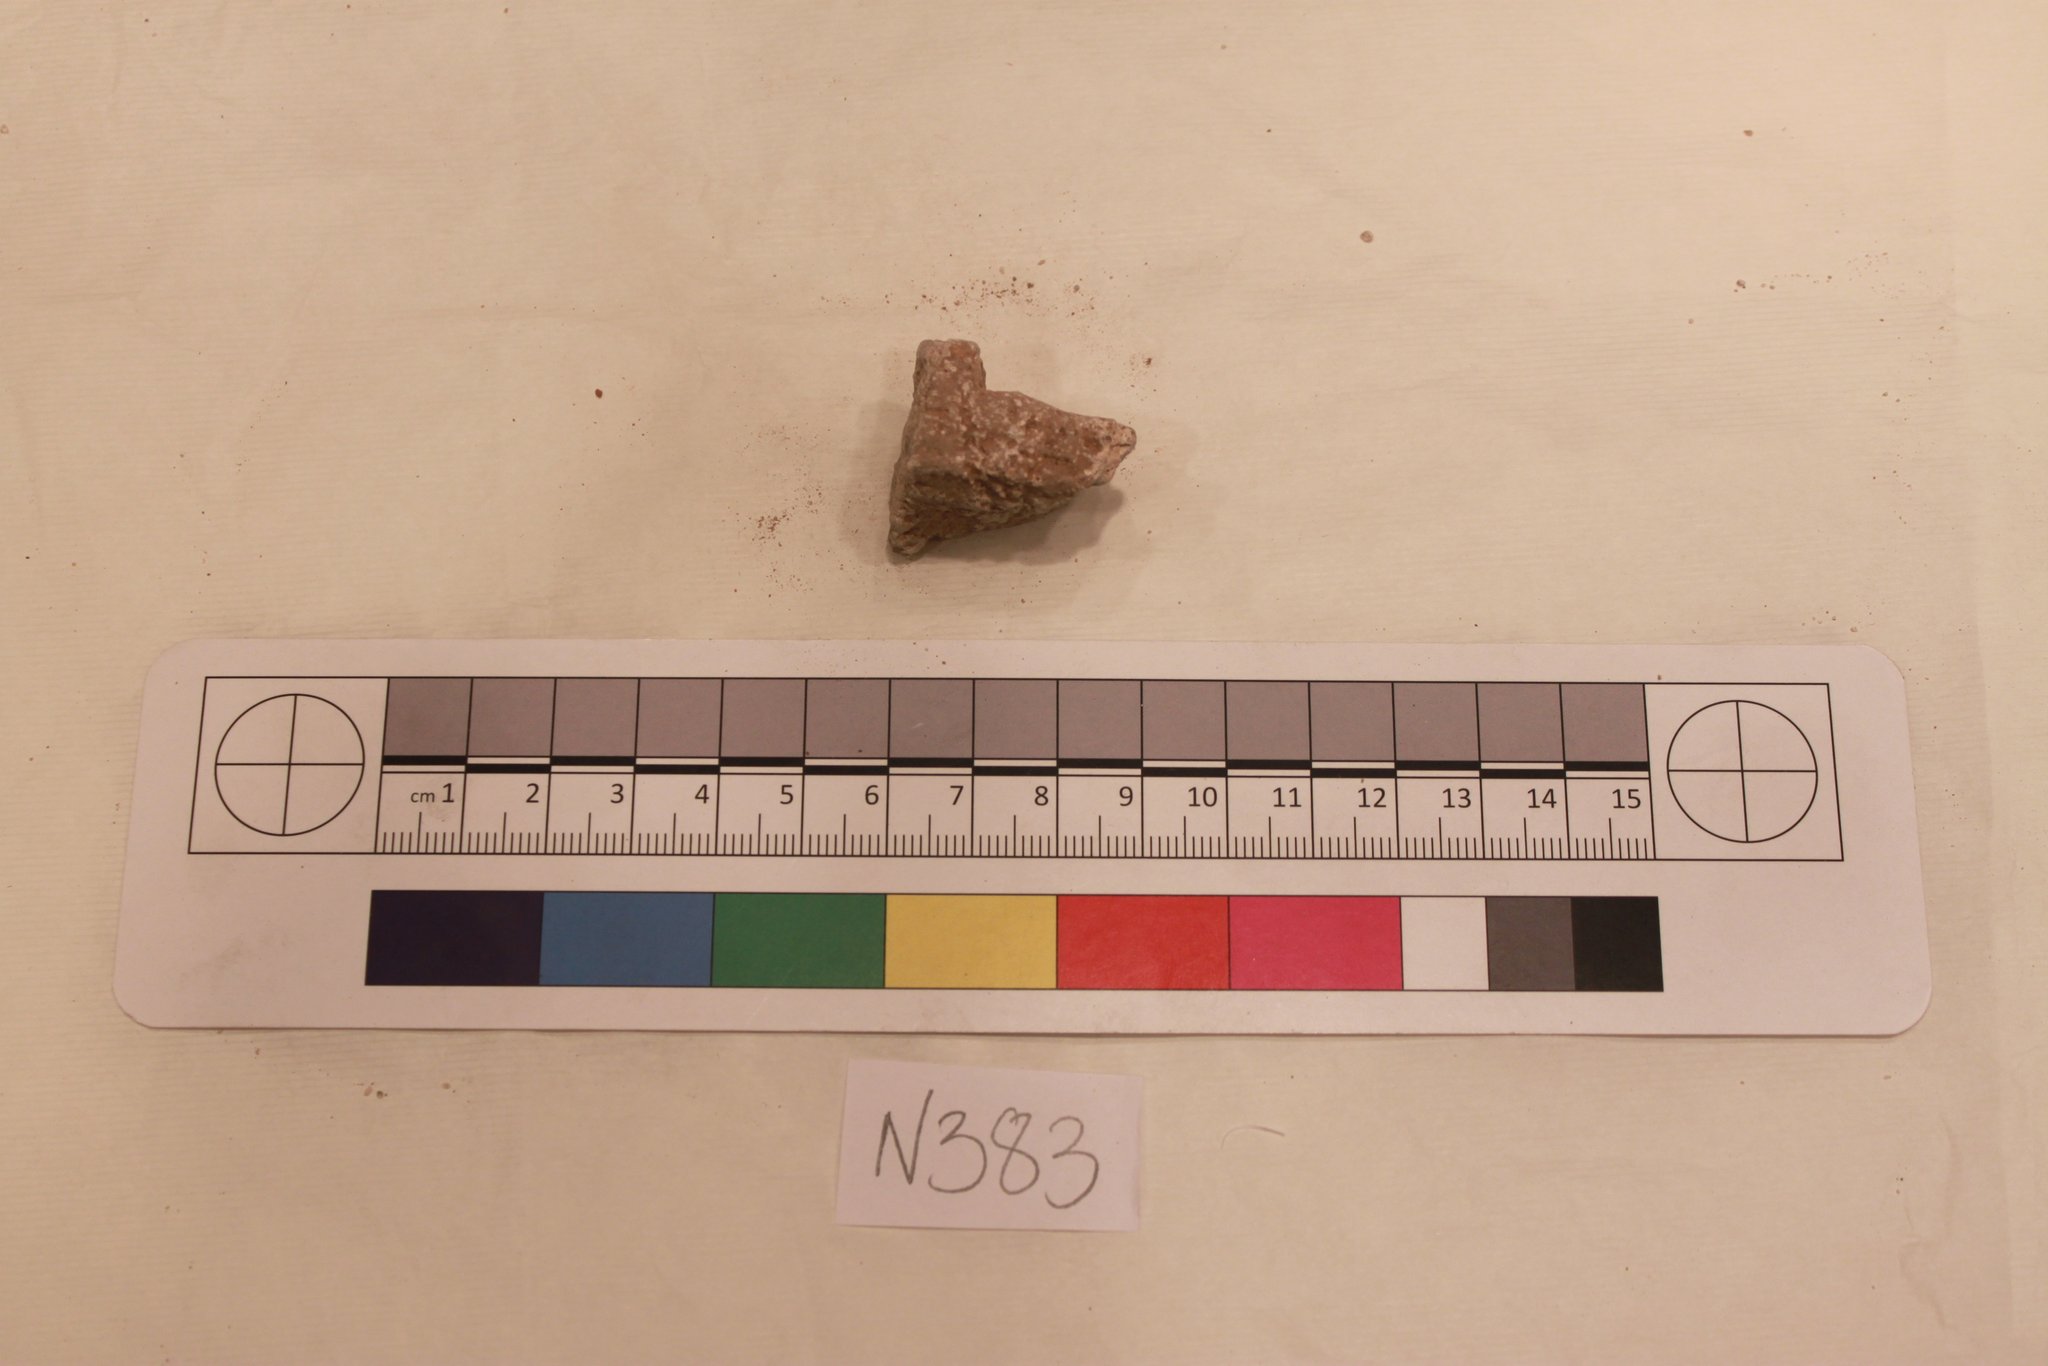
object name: fragment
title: Stucco Fragment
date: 701-1200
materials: plaster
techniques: carving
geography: iran